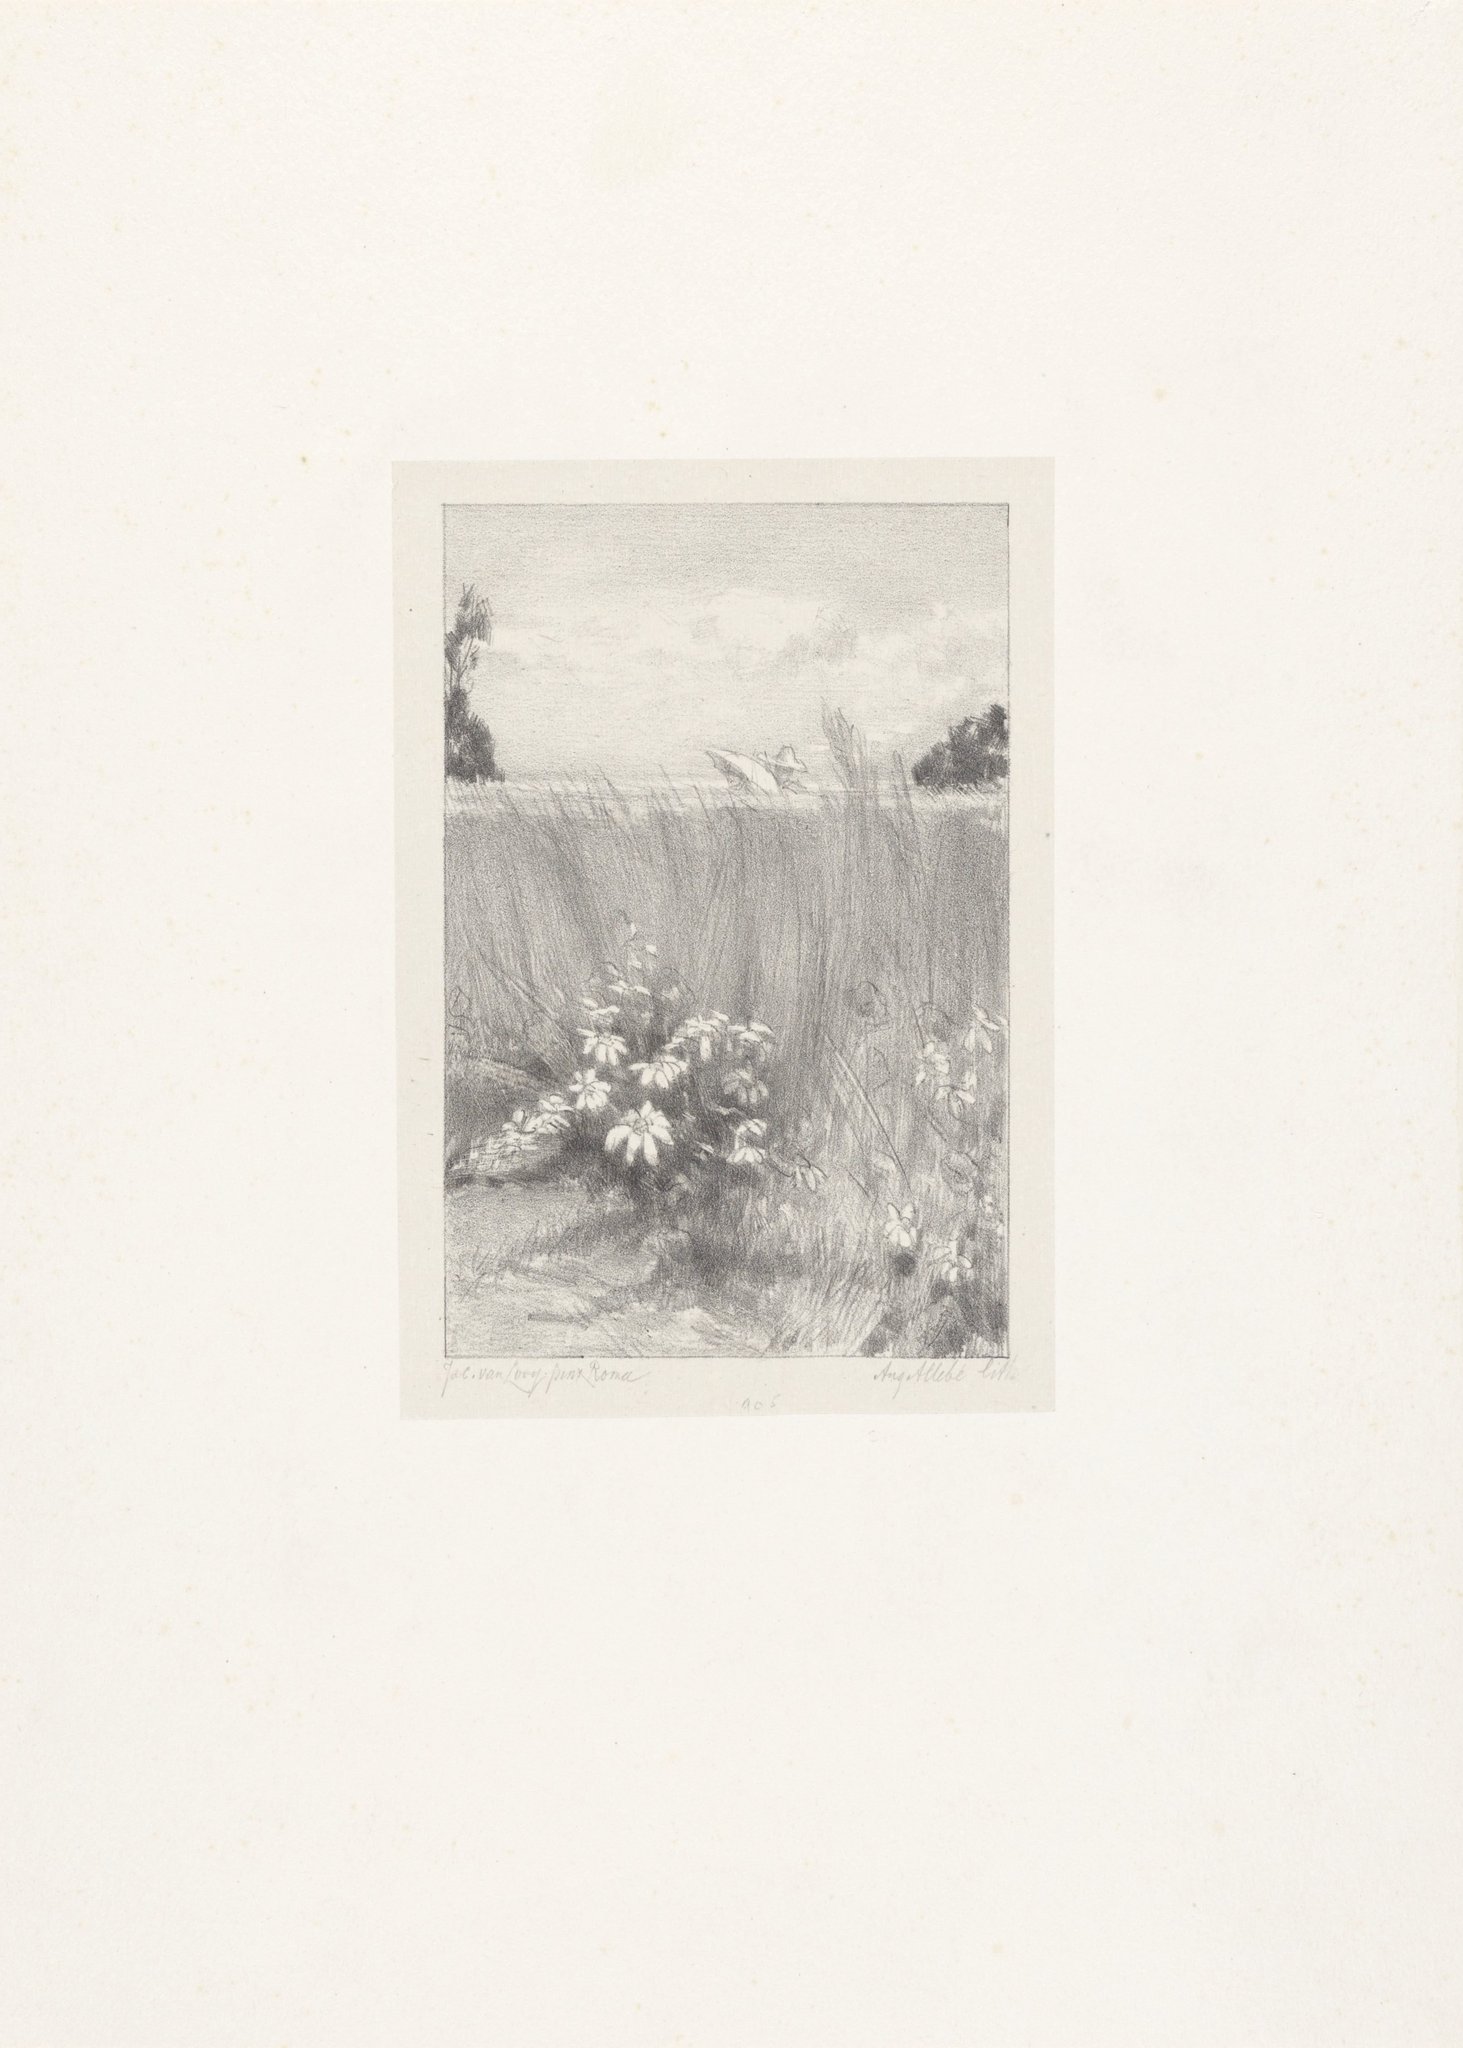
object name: print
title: Korenveld bij Rome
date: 1848-1927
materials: paper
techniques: lithography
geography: netherlands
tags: field filled with a crop, umbrella, landscapes (+ landscape with figures, staffage)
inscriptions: collector's mark: Lugt 2228, inscription: ‘Aug Allebé lith’, inscription: ‘Jac. van Looy pinx Roma’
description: Door een korenveld lopen een man en een vrouw. Hun parasol en hoed steken boven het maaiveld uit.